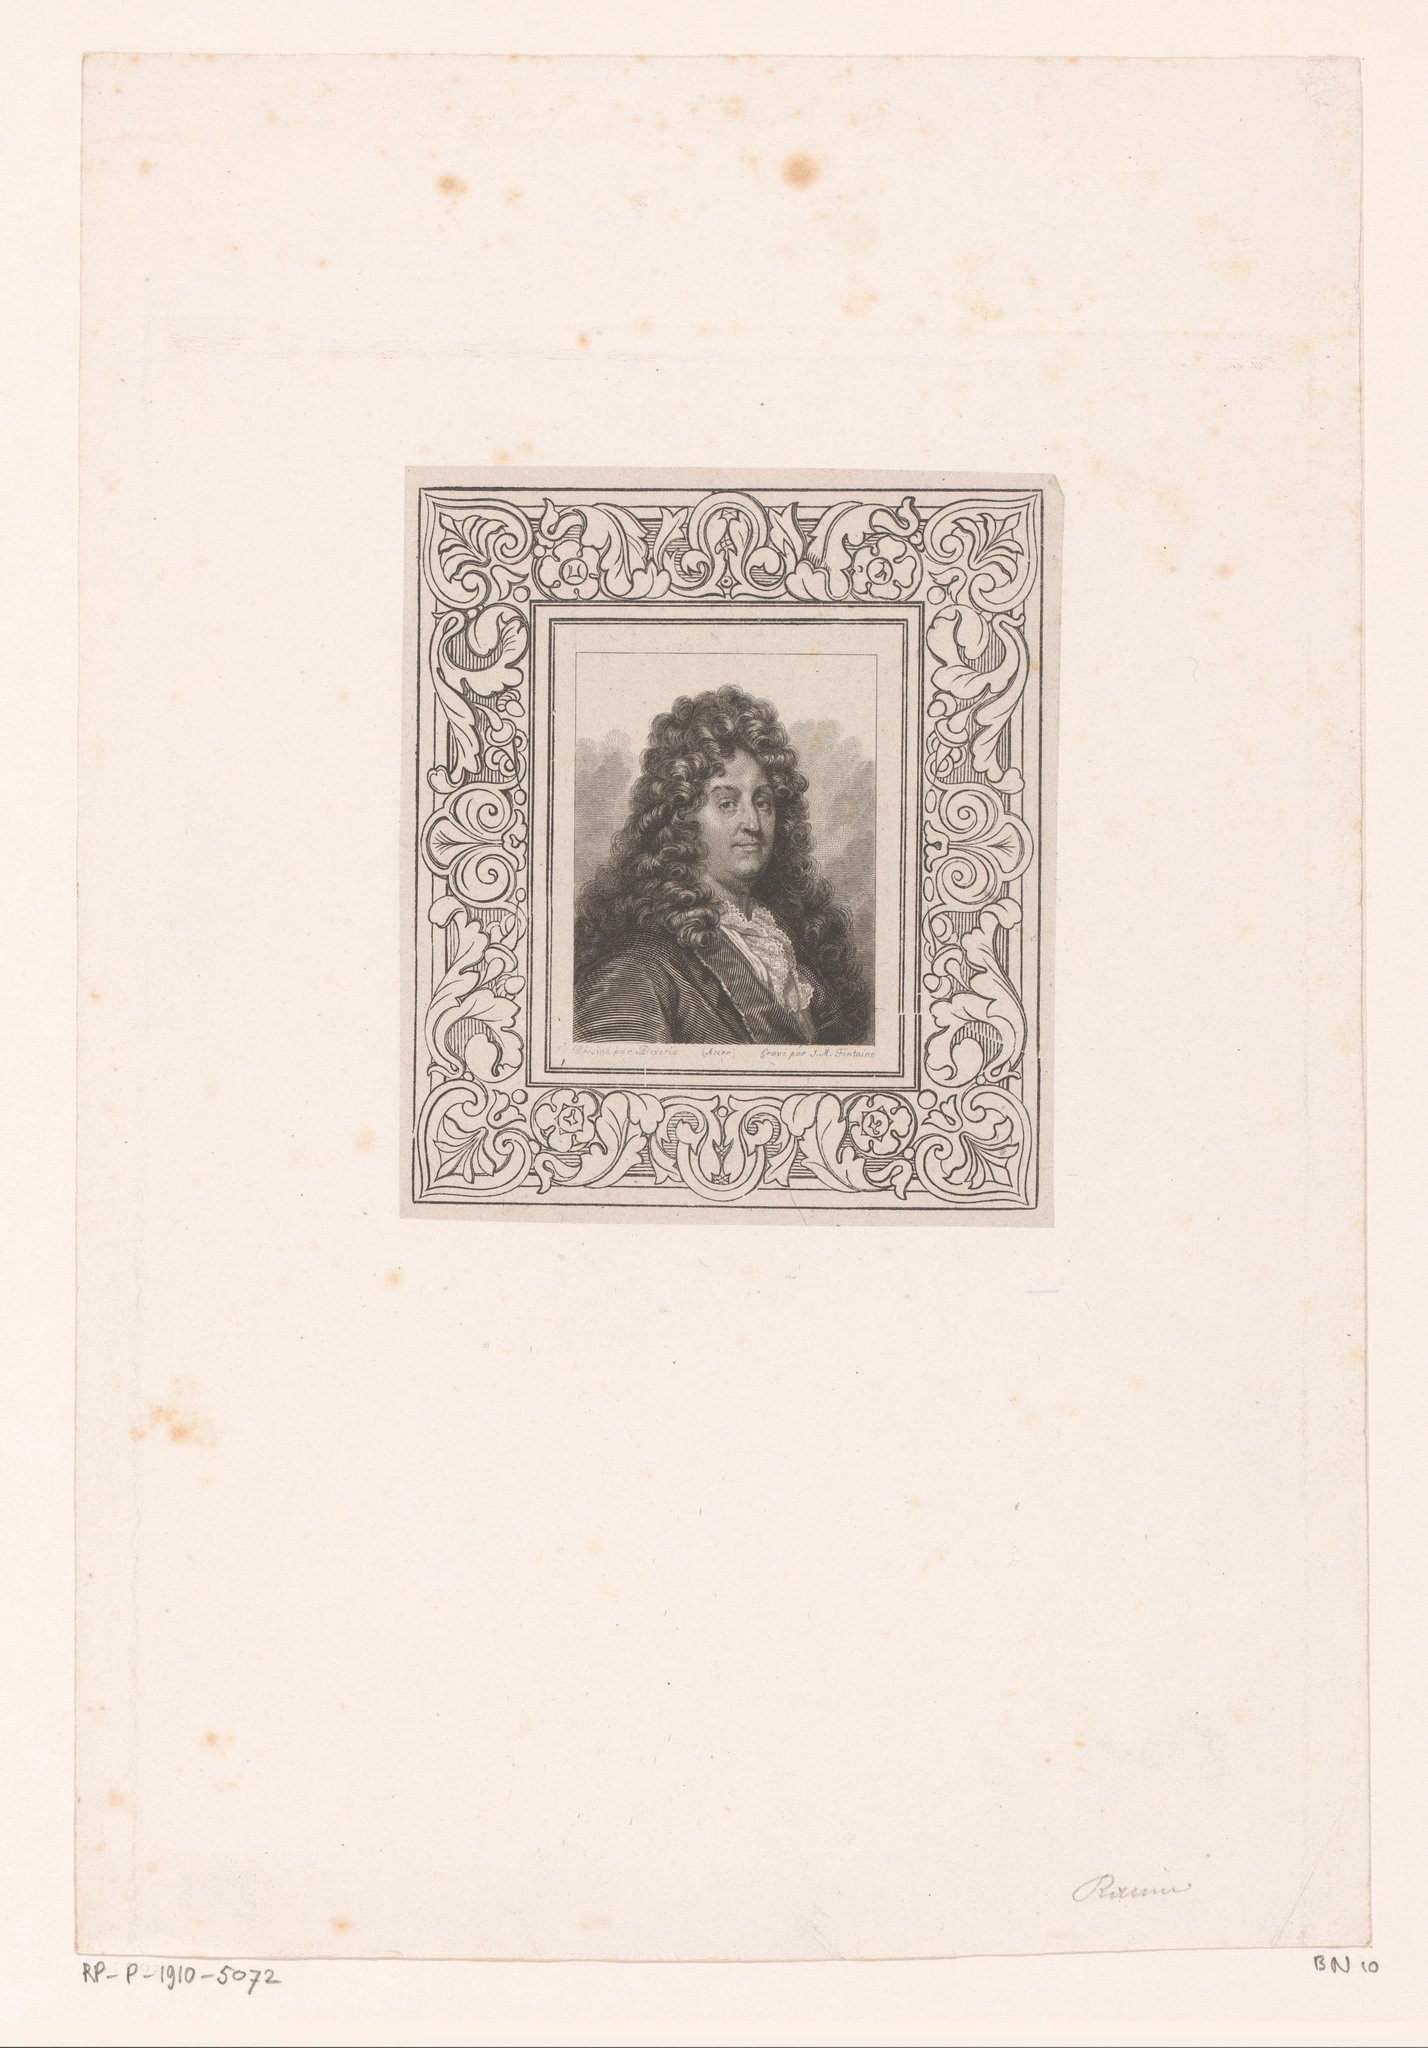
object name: book illustration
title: Portret van Jean Racine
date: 1827-1829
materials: paper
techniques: engraving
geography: france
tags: france, paris, jean racine, historical persons, portrait of a writer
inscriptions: collector's mark: Lugt 2228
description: Volgens de literatuur betreft deze of een andere staat een prent uit: Jarry de Mancy, Adrien. Iconographie instructive, ou Collection de portraits des personnages les plus célèbres de l'histoire moderne, accompagnés et entourés d'une notice biographique, chronologique et bibliographique (...). Parijs: s.n., 1827.